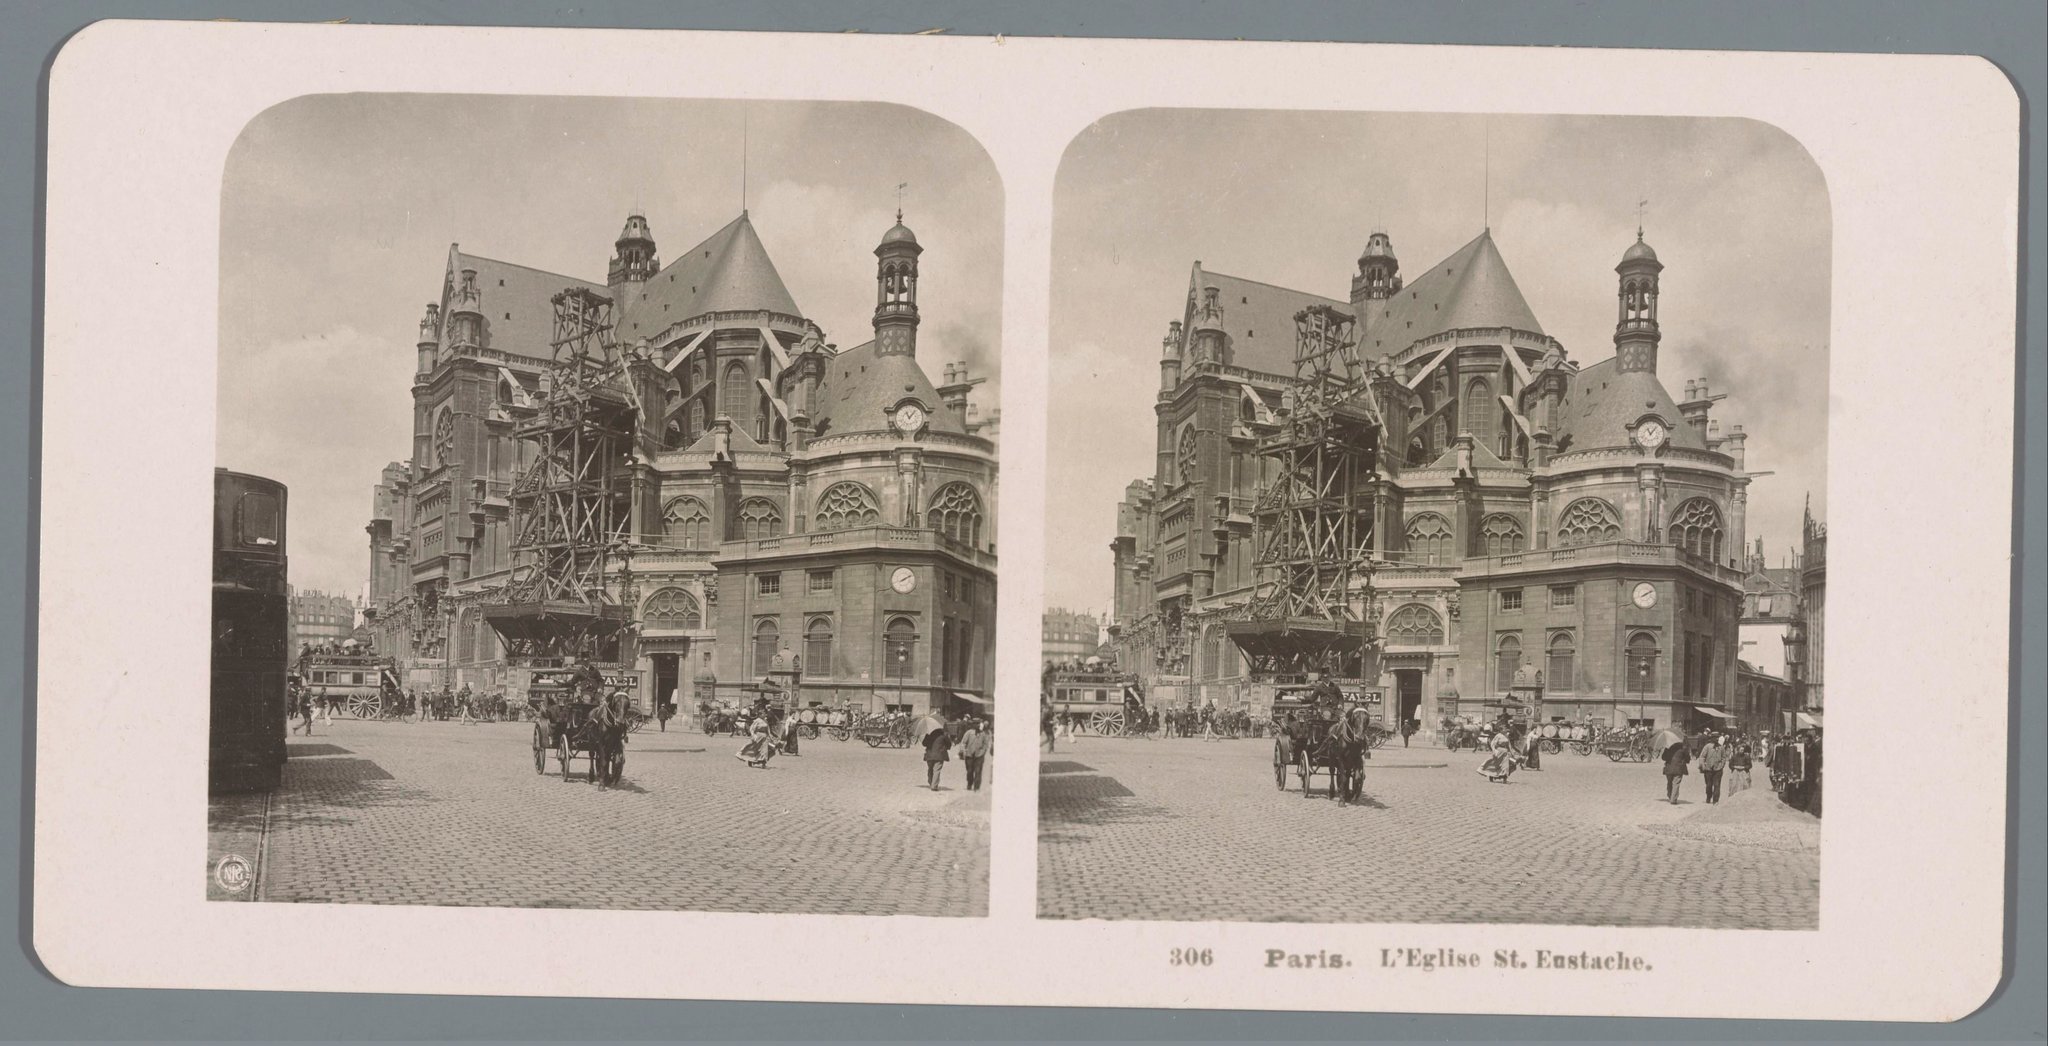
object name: stereograph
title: Paris. L'Eglise St. Eustache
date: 1900-1910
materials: cardboard, photographic support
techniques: gelatin silver print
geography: paris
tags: church (exterior), façade (of house or building)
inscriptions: number: ‘306’, inscription: ‘NPG’